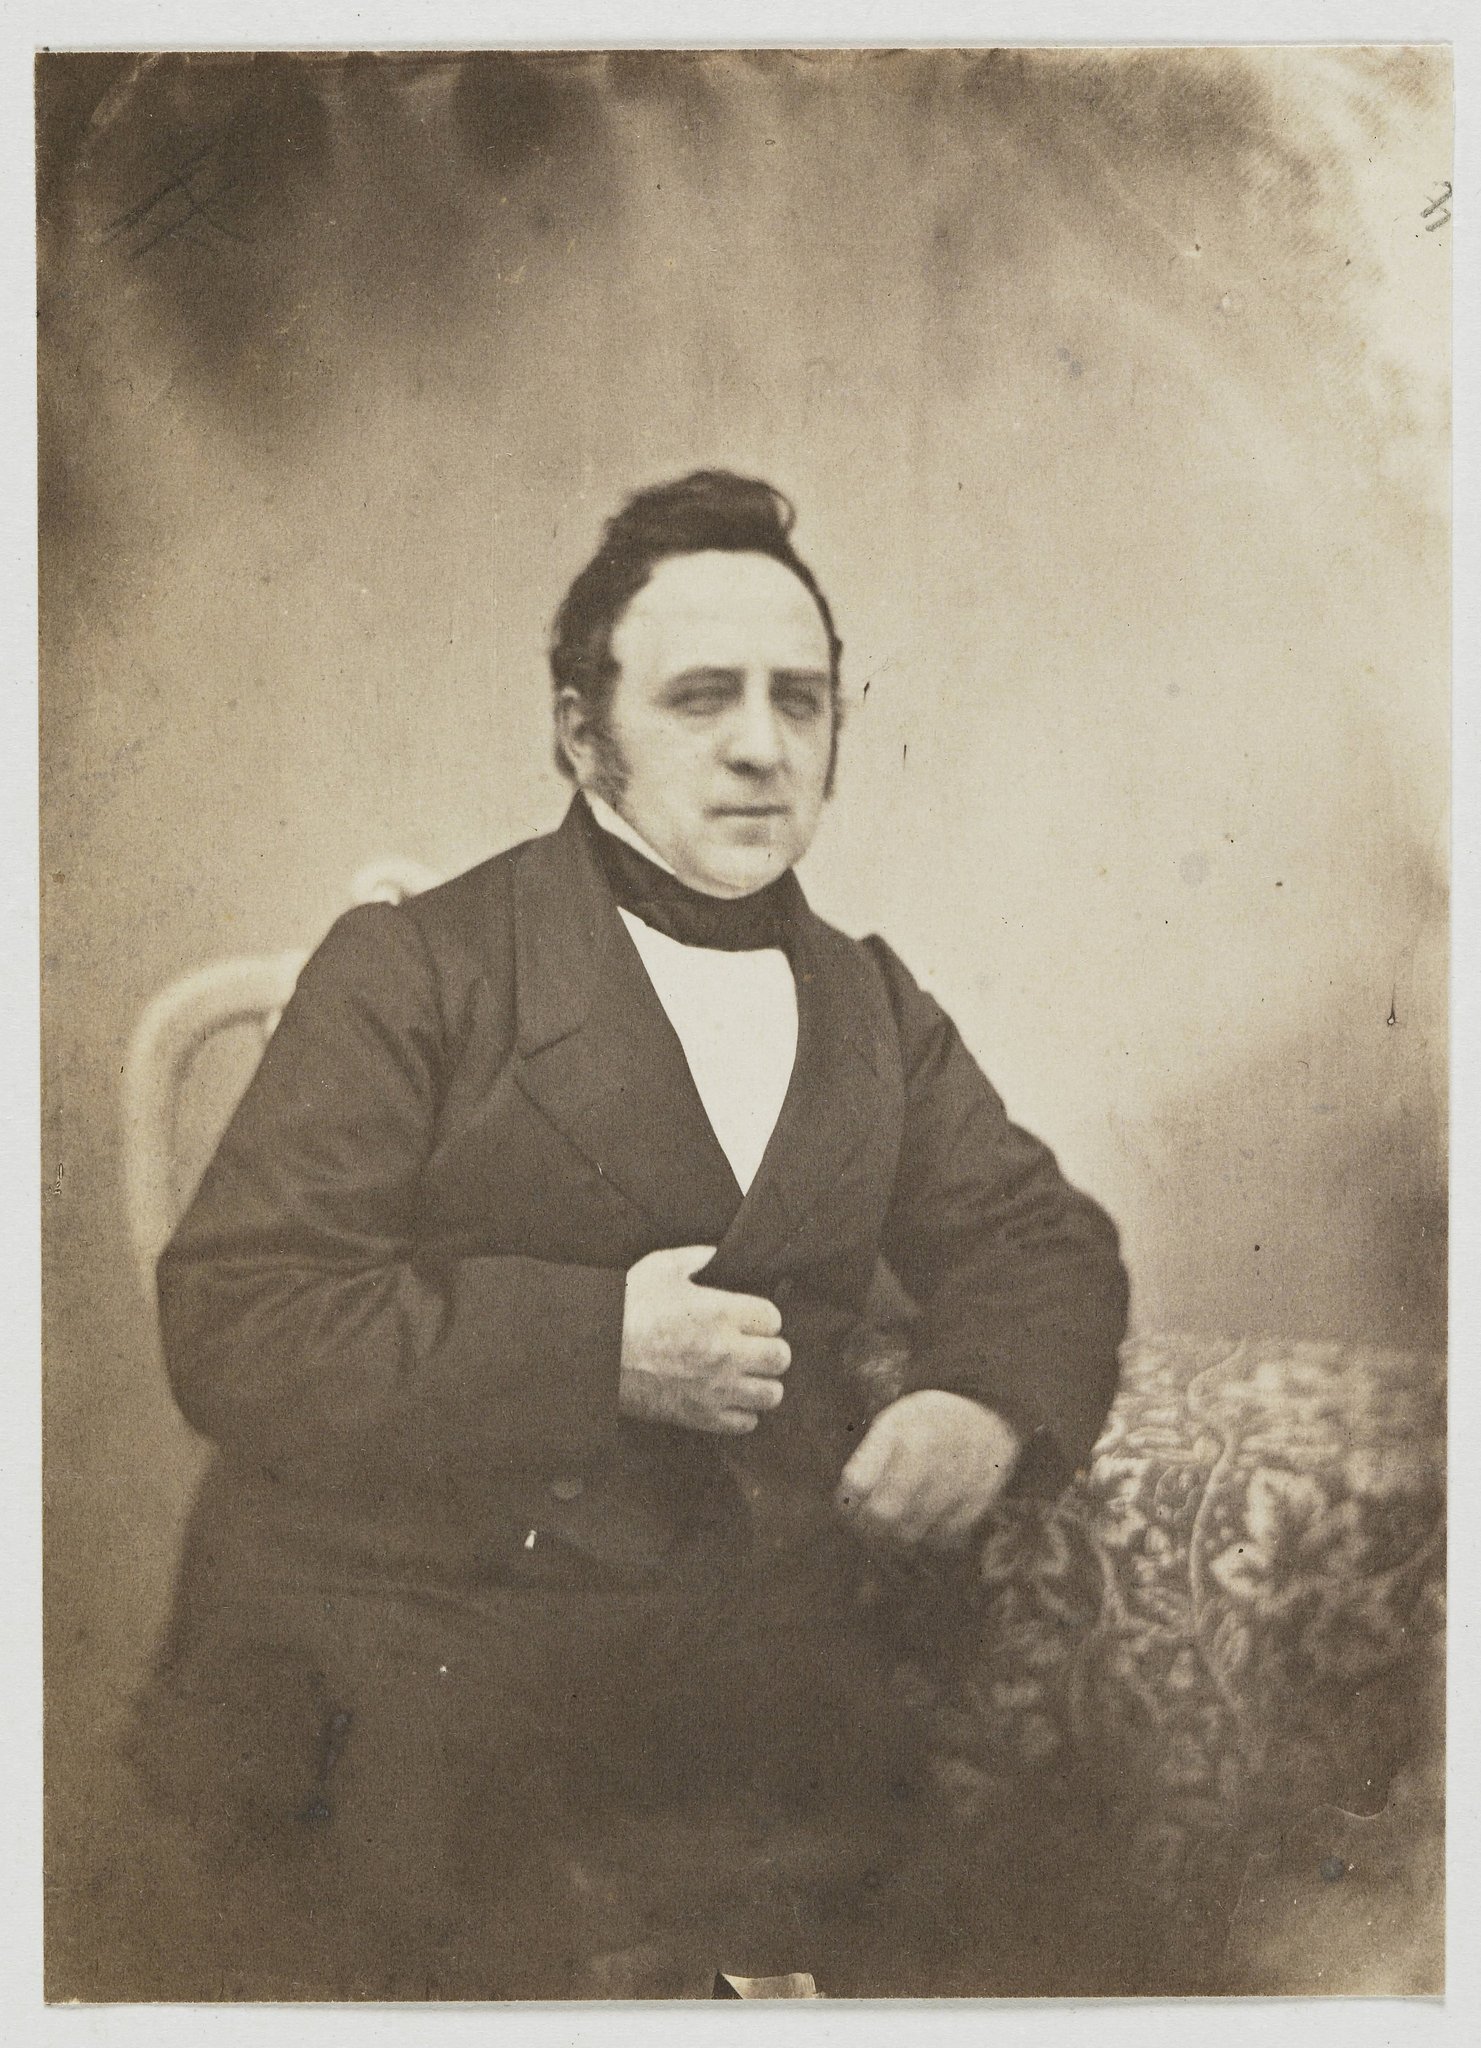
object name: photograph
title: Portret van Johannes Jacobus Prins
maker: Anonymous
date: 1855-1870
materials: paper, photographic support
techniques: salted paper print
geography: netherlands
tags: leiden, theologian, historical persons